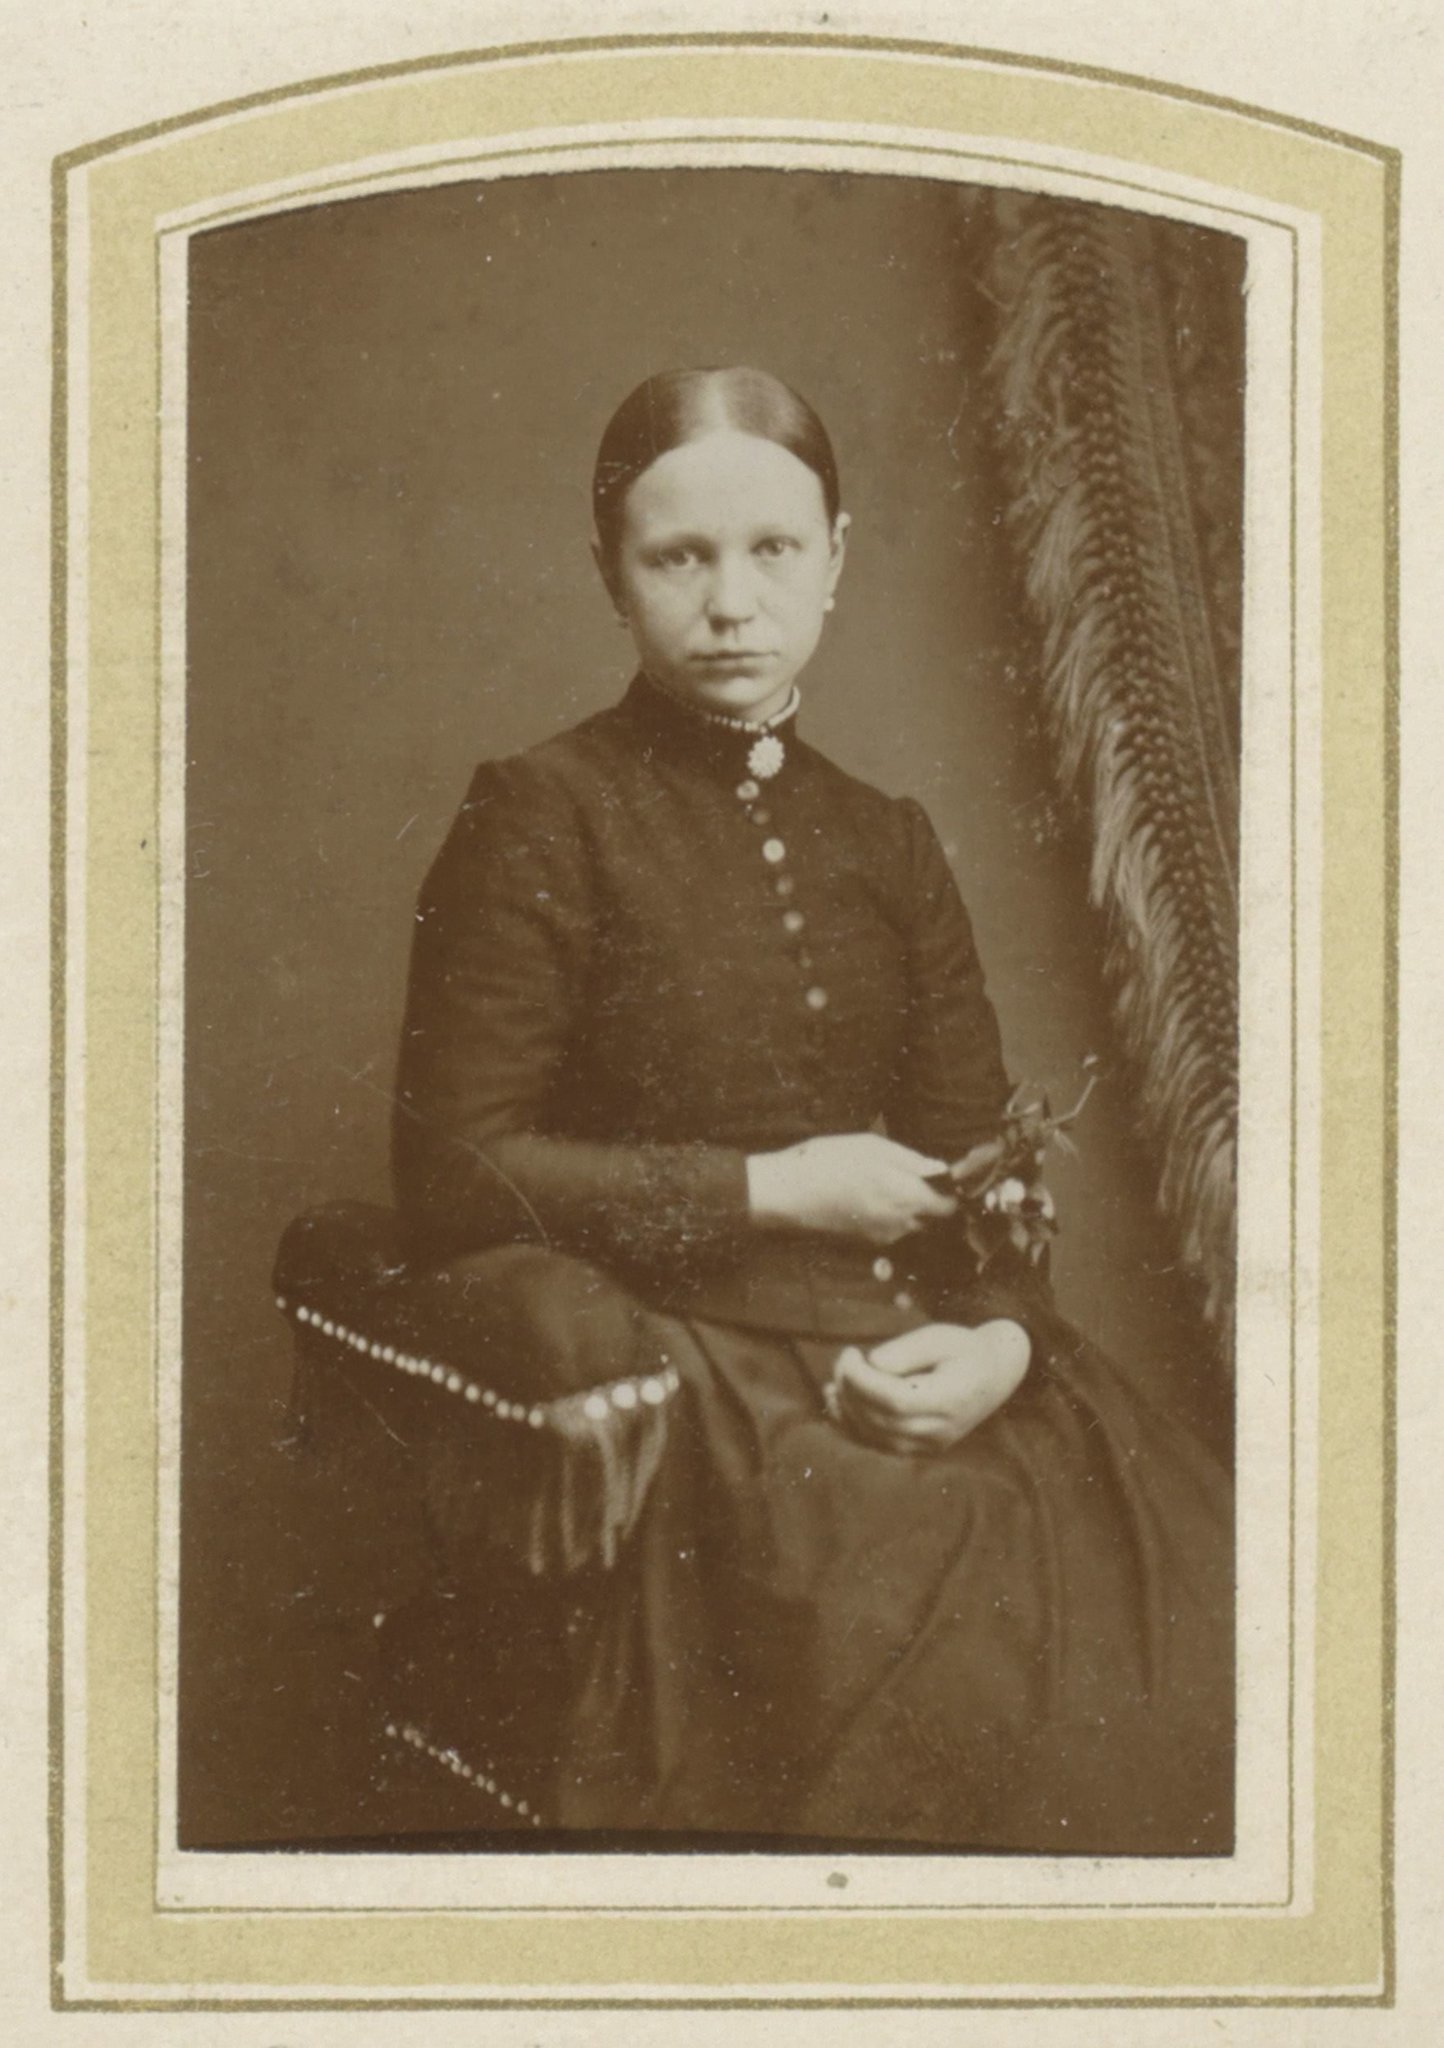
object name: photograph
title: Portret van een zittende vrouw in een lange jurk met een takje in de hand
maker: h. bulens jr.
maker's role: fotograaf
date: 1860-1900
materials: cardboard, paper, photographic support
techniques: daylight paper print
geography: winterswijk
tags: studio requisites ~ photographer, historical persons, styles of hairdress - aa - ~ women, clothing for the upper part of the body, skirt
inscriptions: address: ‘Winterswijk’, address: ‘Spoorstraat Winterswijk’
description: Onderdeel van Fotoalbum van een Nederlandse familie met 168 cartes-de-visite en kabinetfoto's.